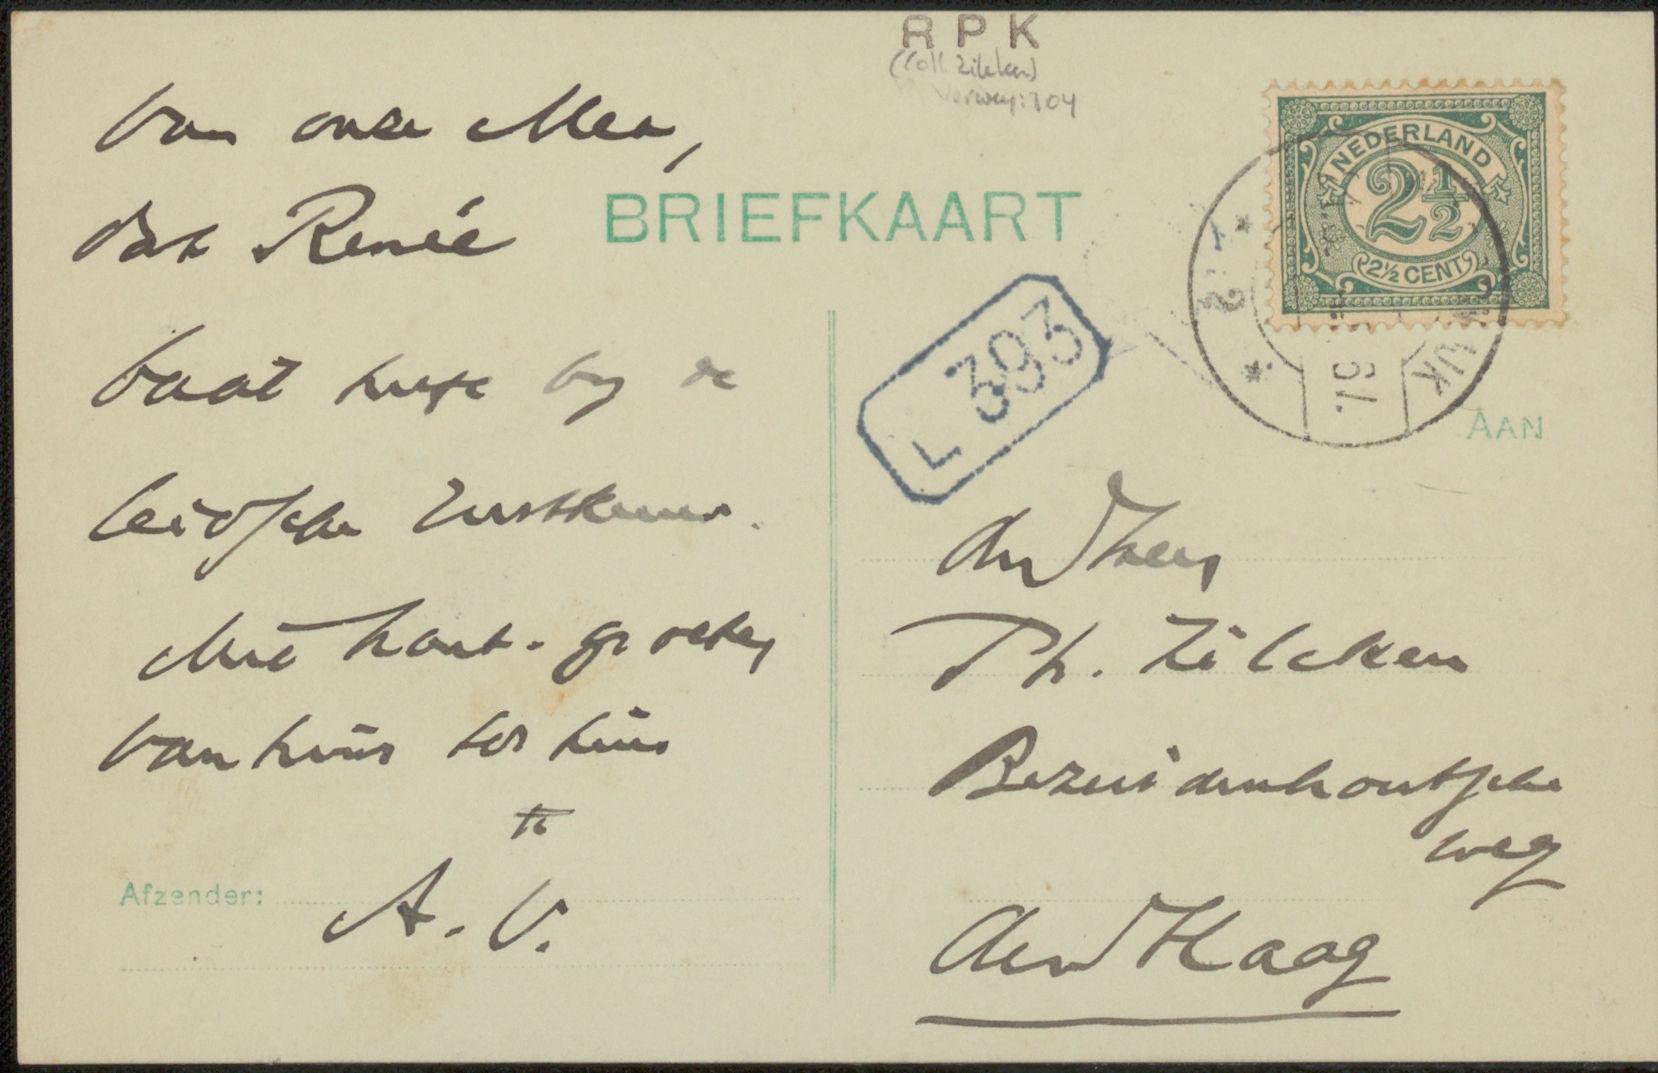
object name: postcard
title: Briefkaart aan Philip Zilcken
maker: albert verwey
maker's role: criticus, dichter, essayist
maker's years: 1865-1937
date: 1875-1930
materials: cardboard, ink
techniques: pen, writing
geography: noordwijk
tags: the hague, painter, draughtsman, philip zilcken, the graphic arts, leiden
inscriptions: collector's mark: ‘RPK’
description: Bij de briefkaart wordt een envelop bewaard.